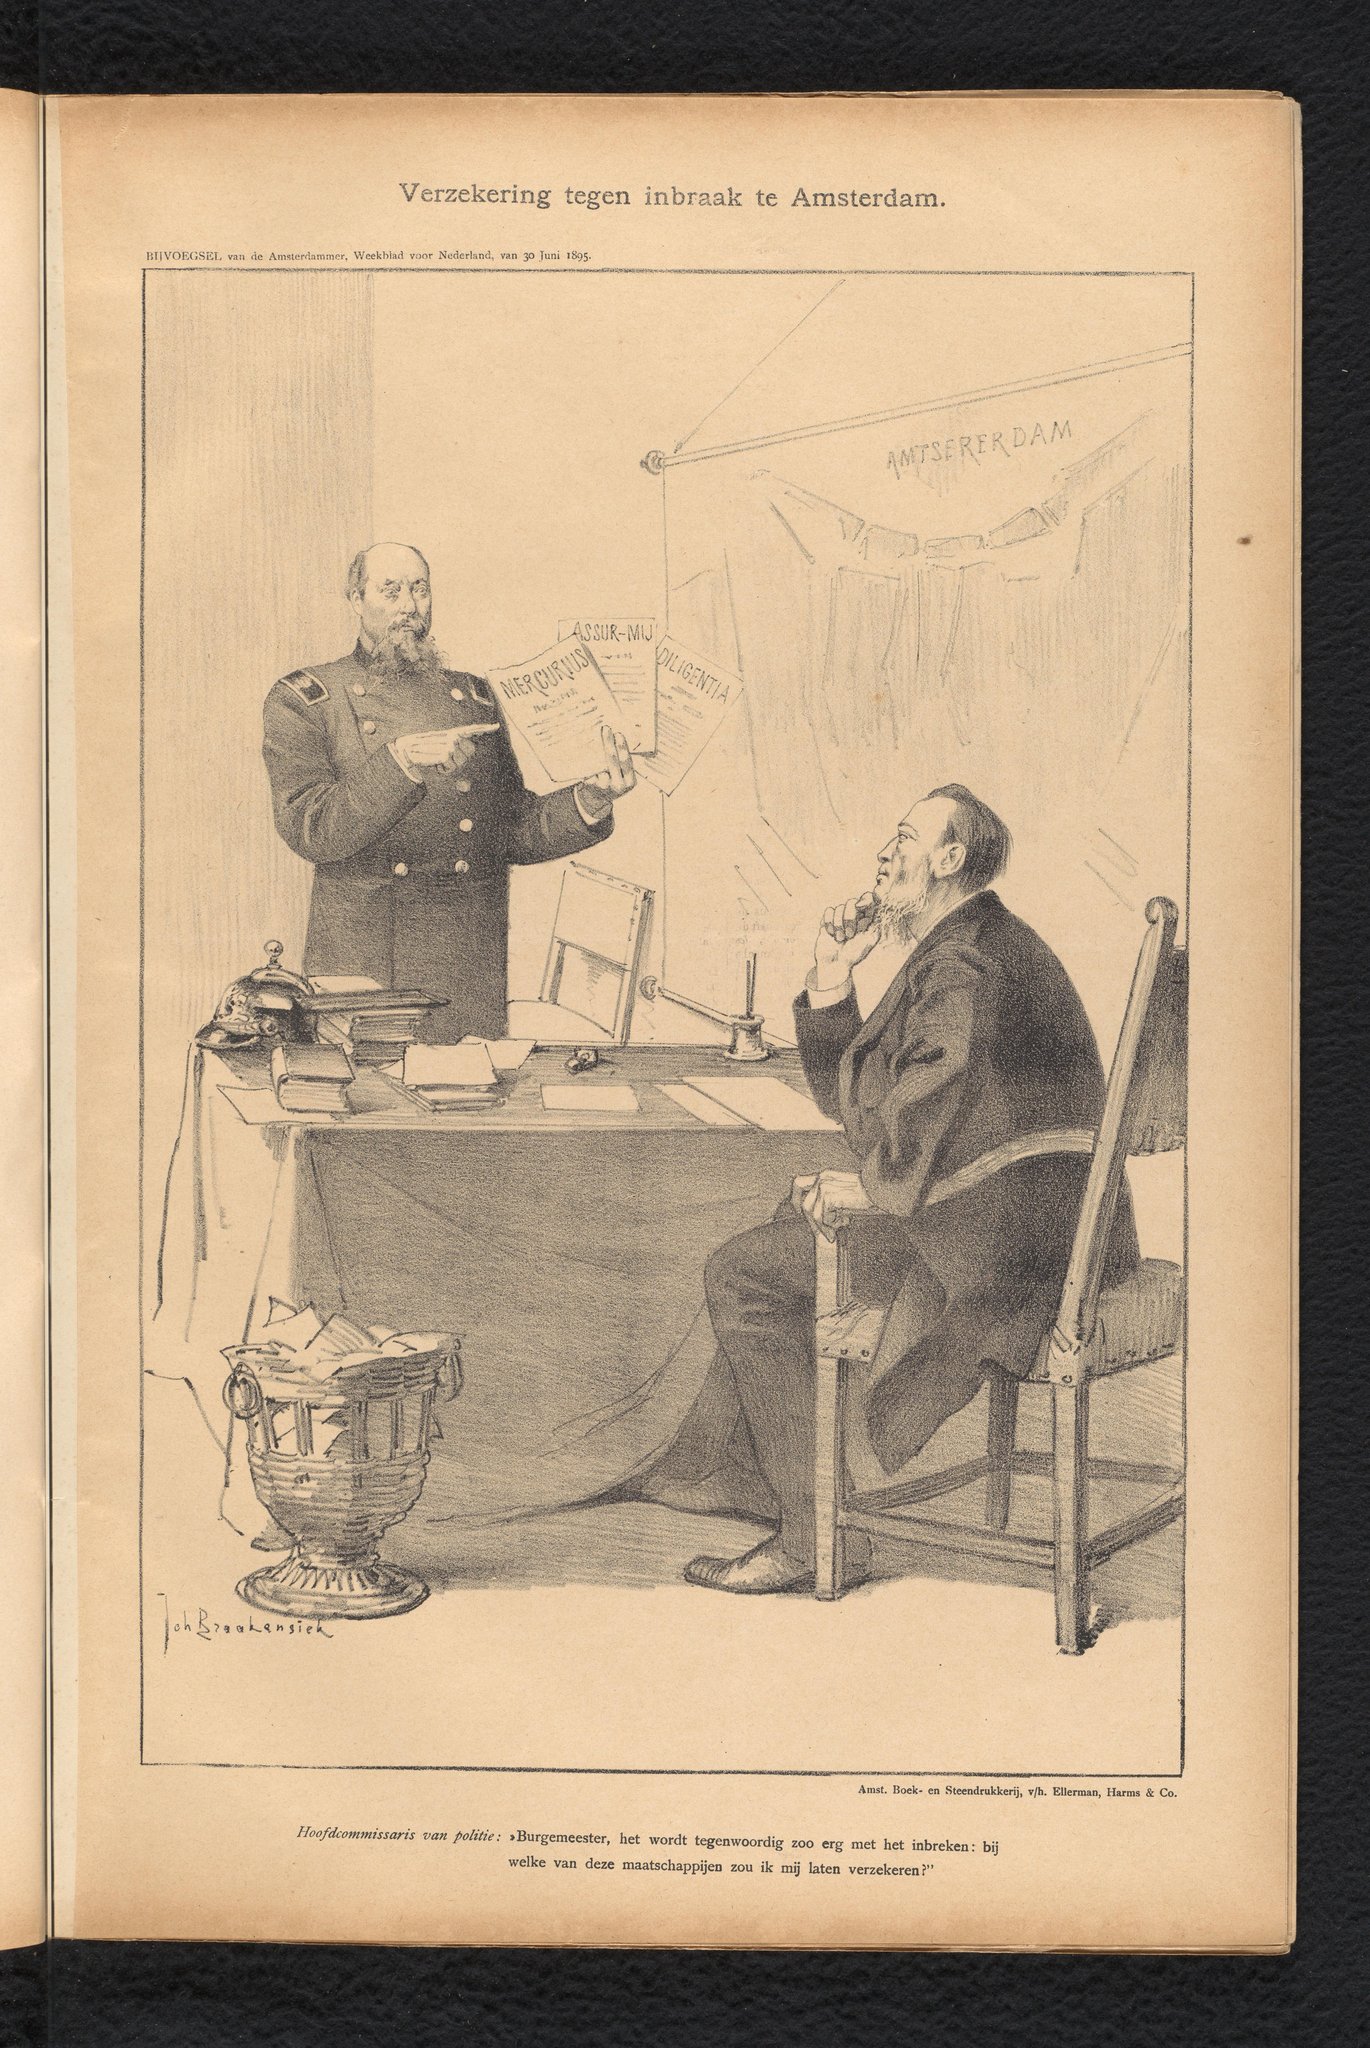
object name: cartoon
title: Verzekering tegen inbraak te Amsterdam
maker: johan braakensiek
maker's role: draughtsman, print maker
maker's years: 1858-1940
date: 1895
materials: paper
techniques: lithograph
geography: netherlands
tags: insurance, mayor, burgomaster, political caricatures and satires, burglary, amsterdam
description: Pieter Willem Steenkamp, de hoofdcommissaris van de Amsterdamse politie, informeert bij burgemeester Vening Meinesz waar hij zich kan laten verzekeren tegen inbraak.